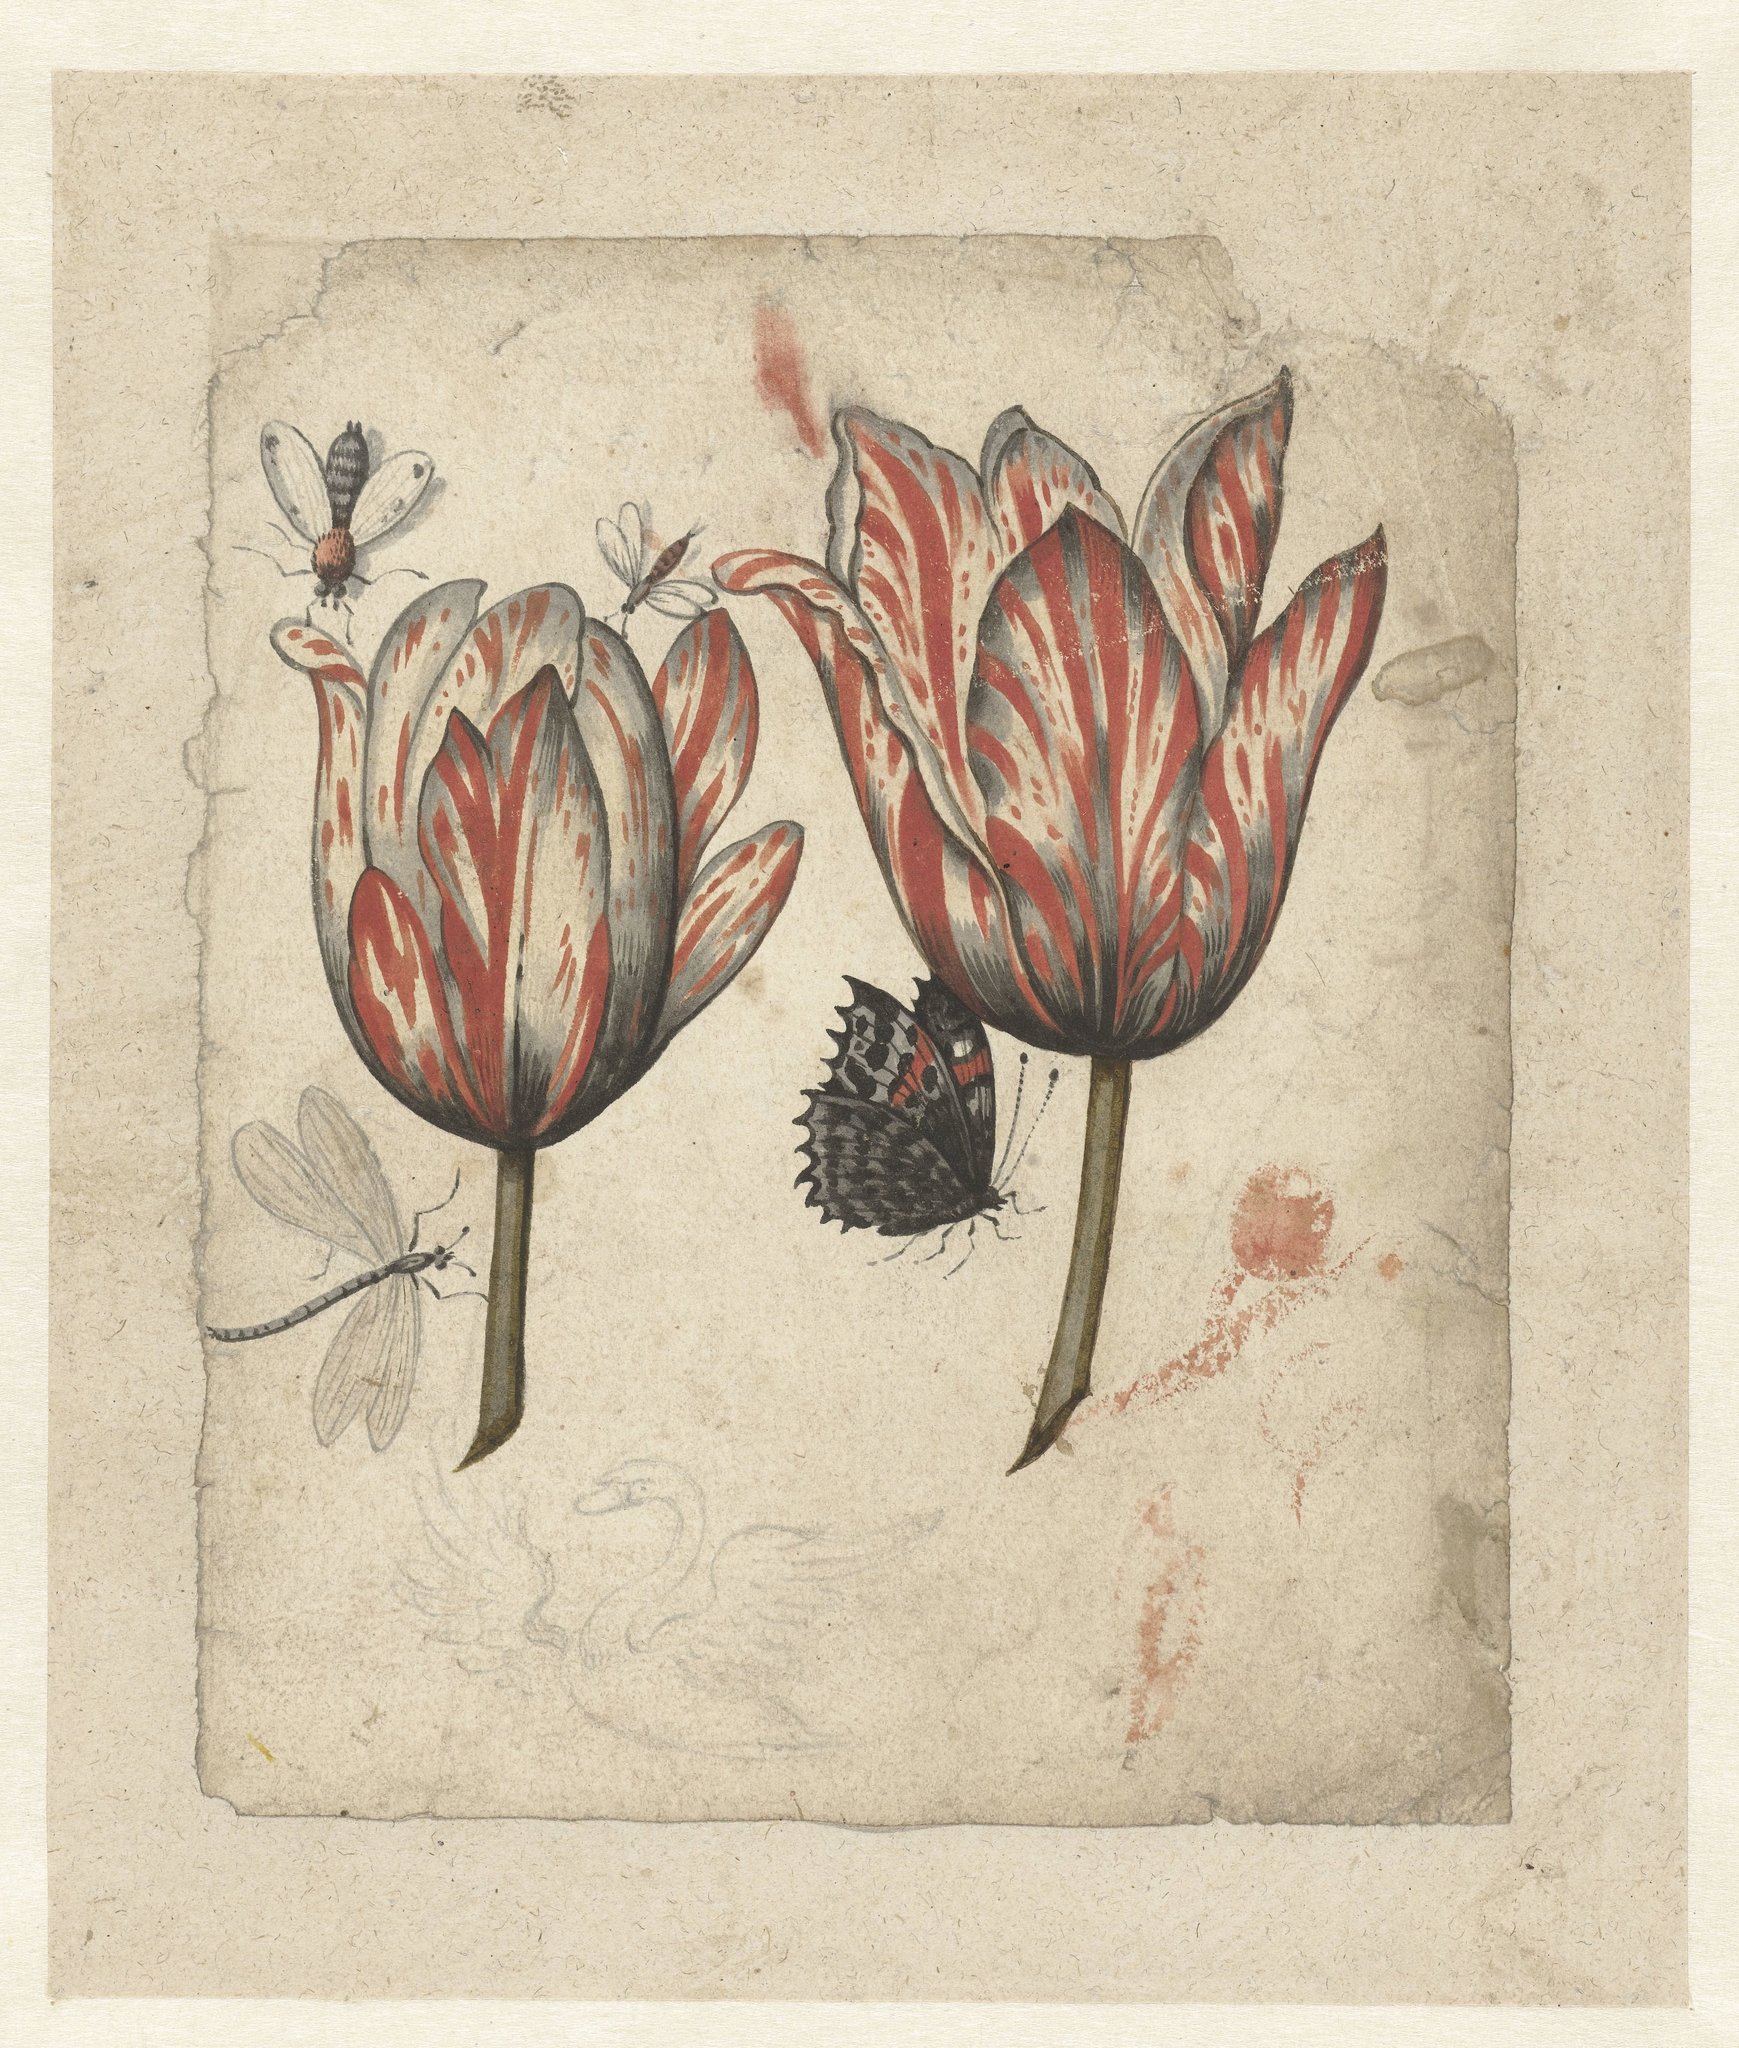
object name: drawing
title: Blad met twee tulpen en enkele insecten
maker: Anonymous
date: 1600-1699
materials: paper, watercolor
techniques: brush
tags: insects: dragon-fly, insects: butterfly, flowers: tulip